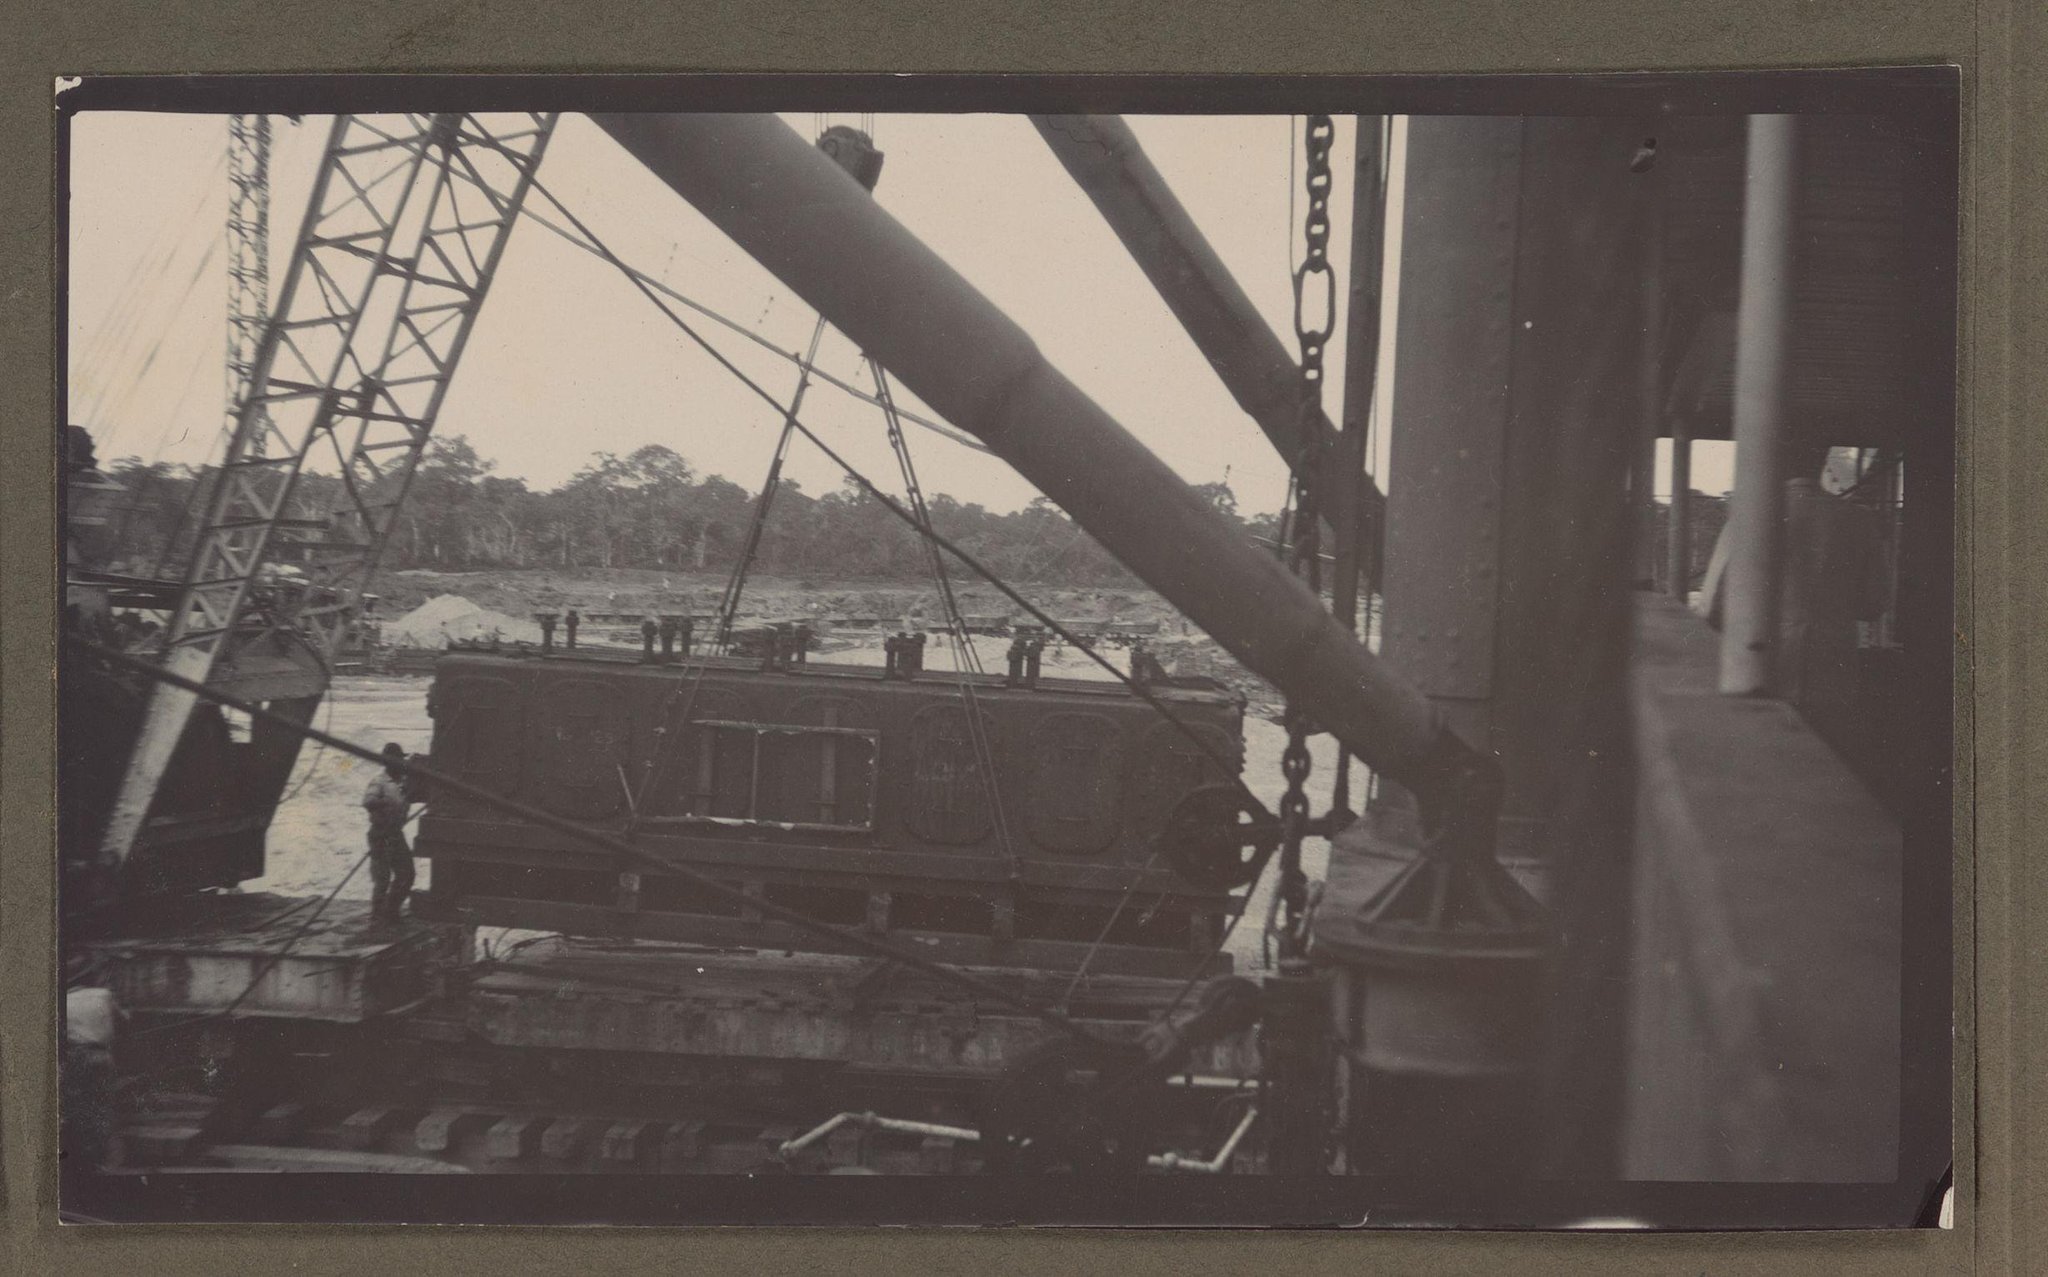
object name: photograph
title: Mijn en fabriek in Moengo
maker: Anonymous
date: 1925-1927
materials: photographic support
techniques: photography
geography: suriname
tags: jetten, familie, moengo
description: Terrein van de mijn en fabriek in Moengo met graafmachine. Foto op een bladzijde van een los albumblad. Onderdeel van het ensemble met foto's van de familie van ingenieur Jetten in de mijnbouwstad Moengo in Suriname.